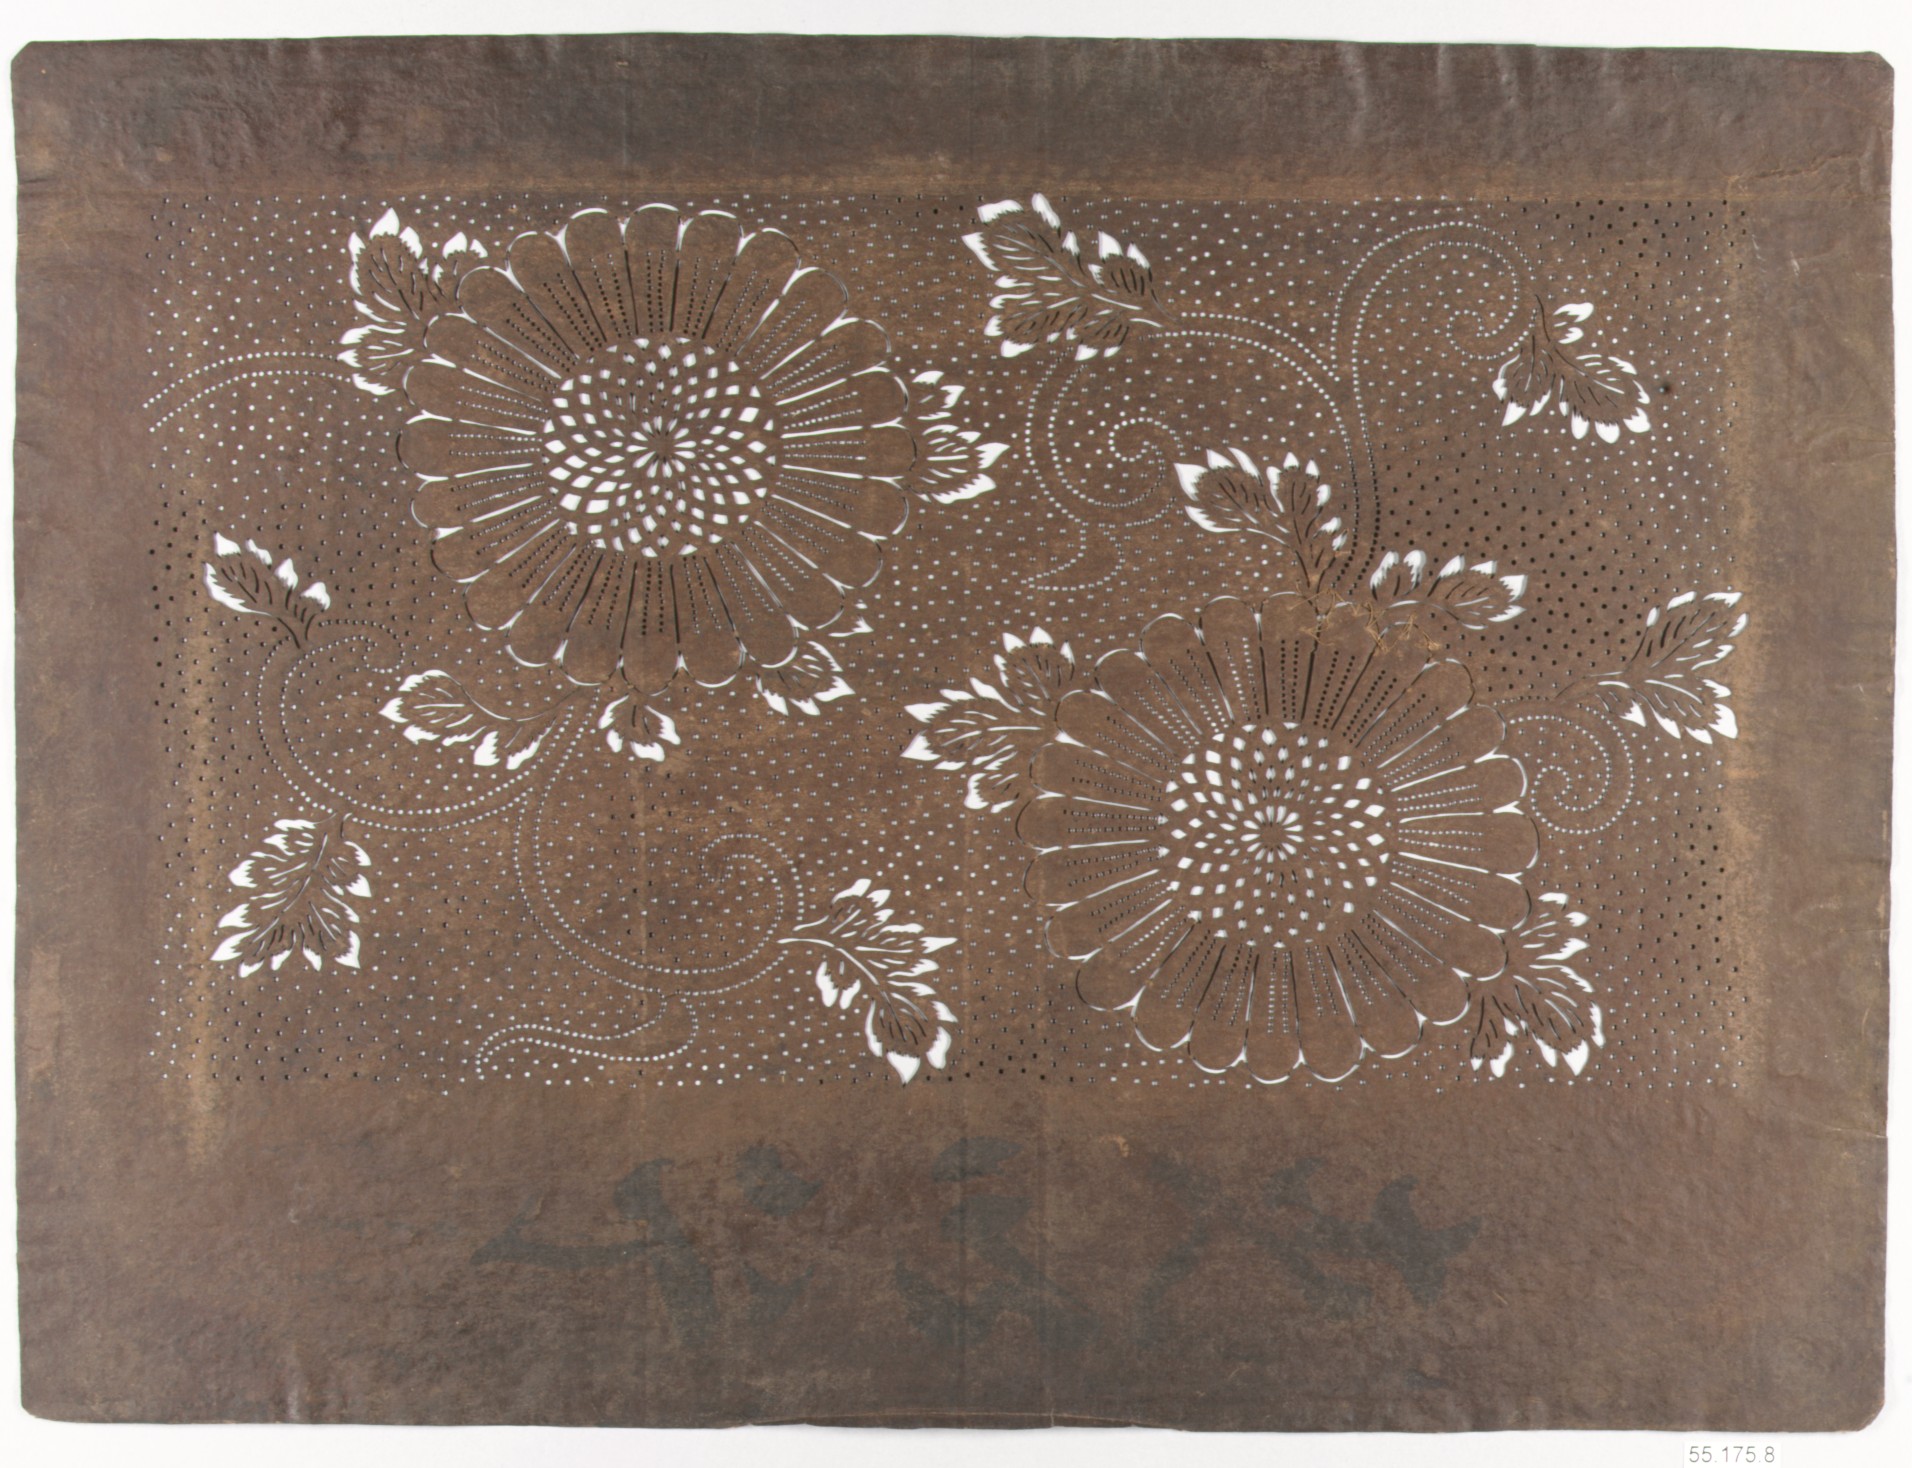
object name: stencil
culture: japanese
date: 1801-1900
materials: paper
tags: flowers